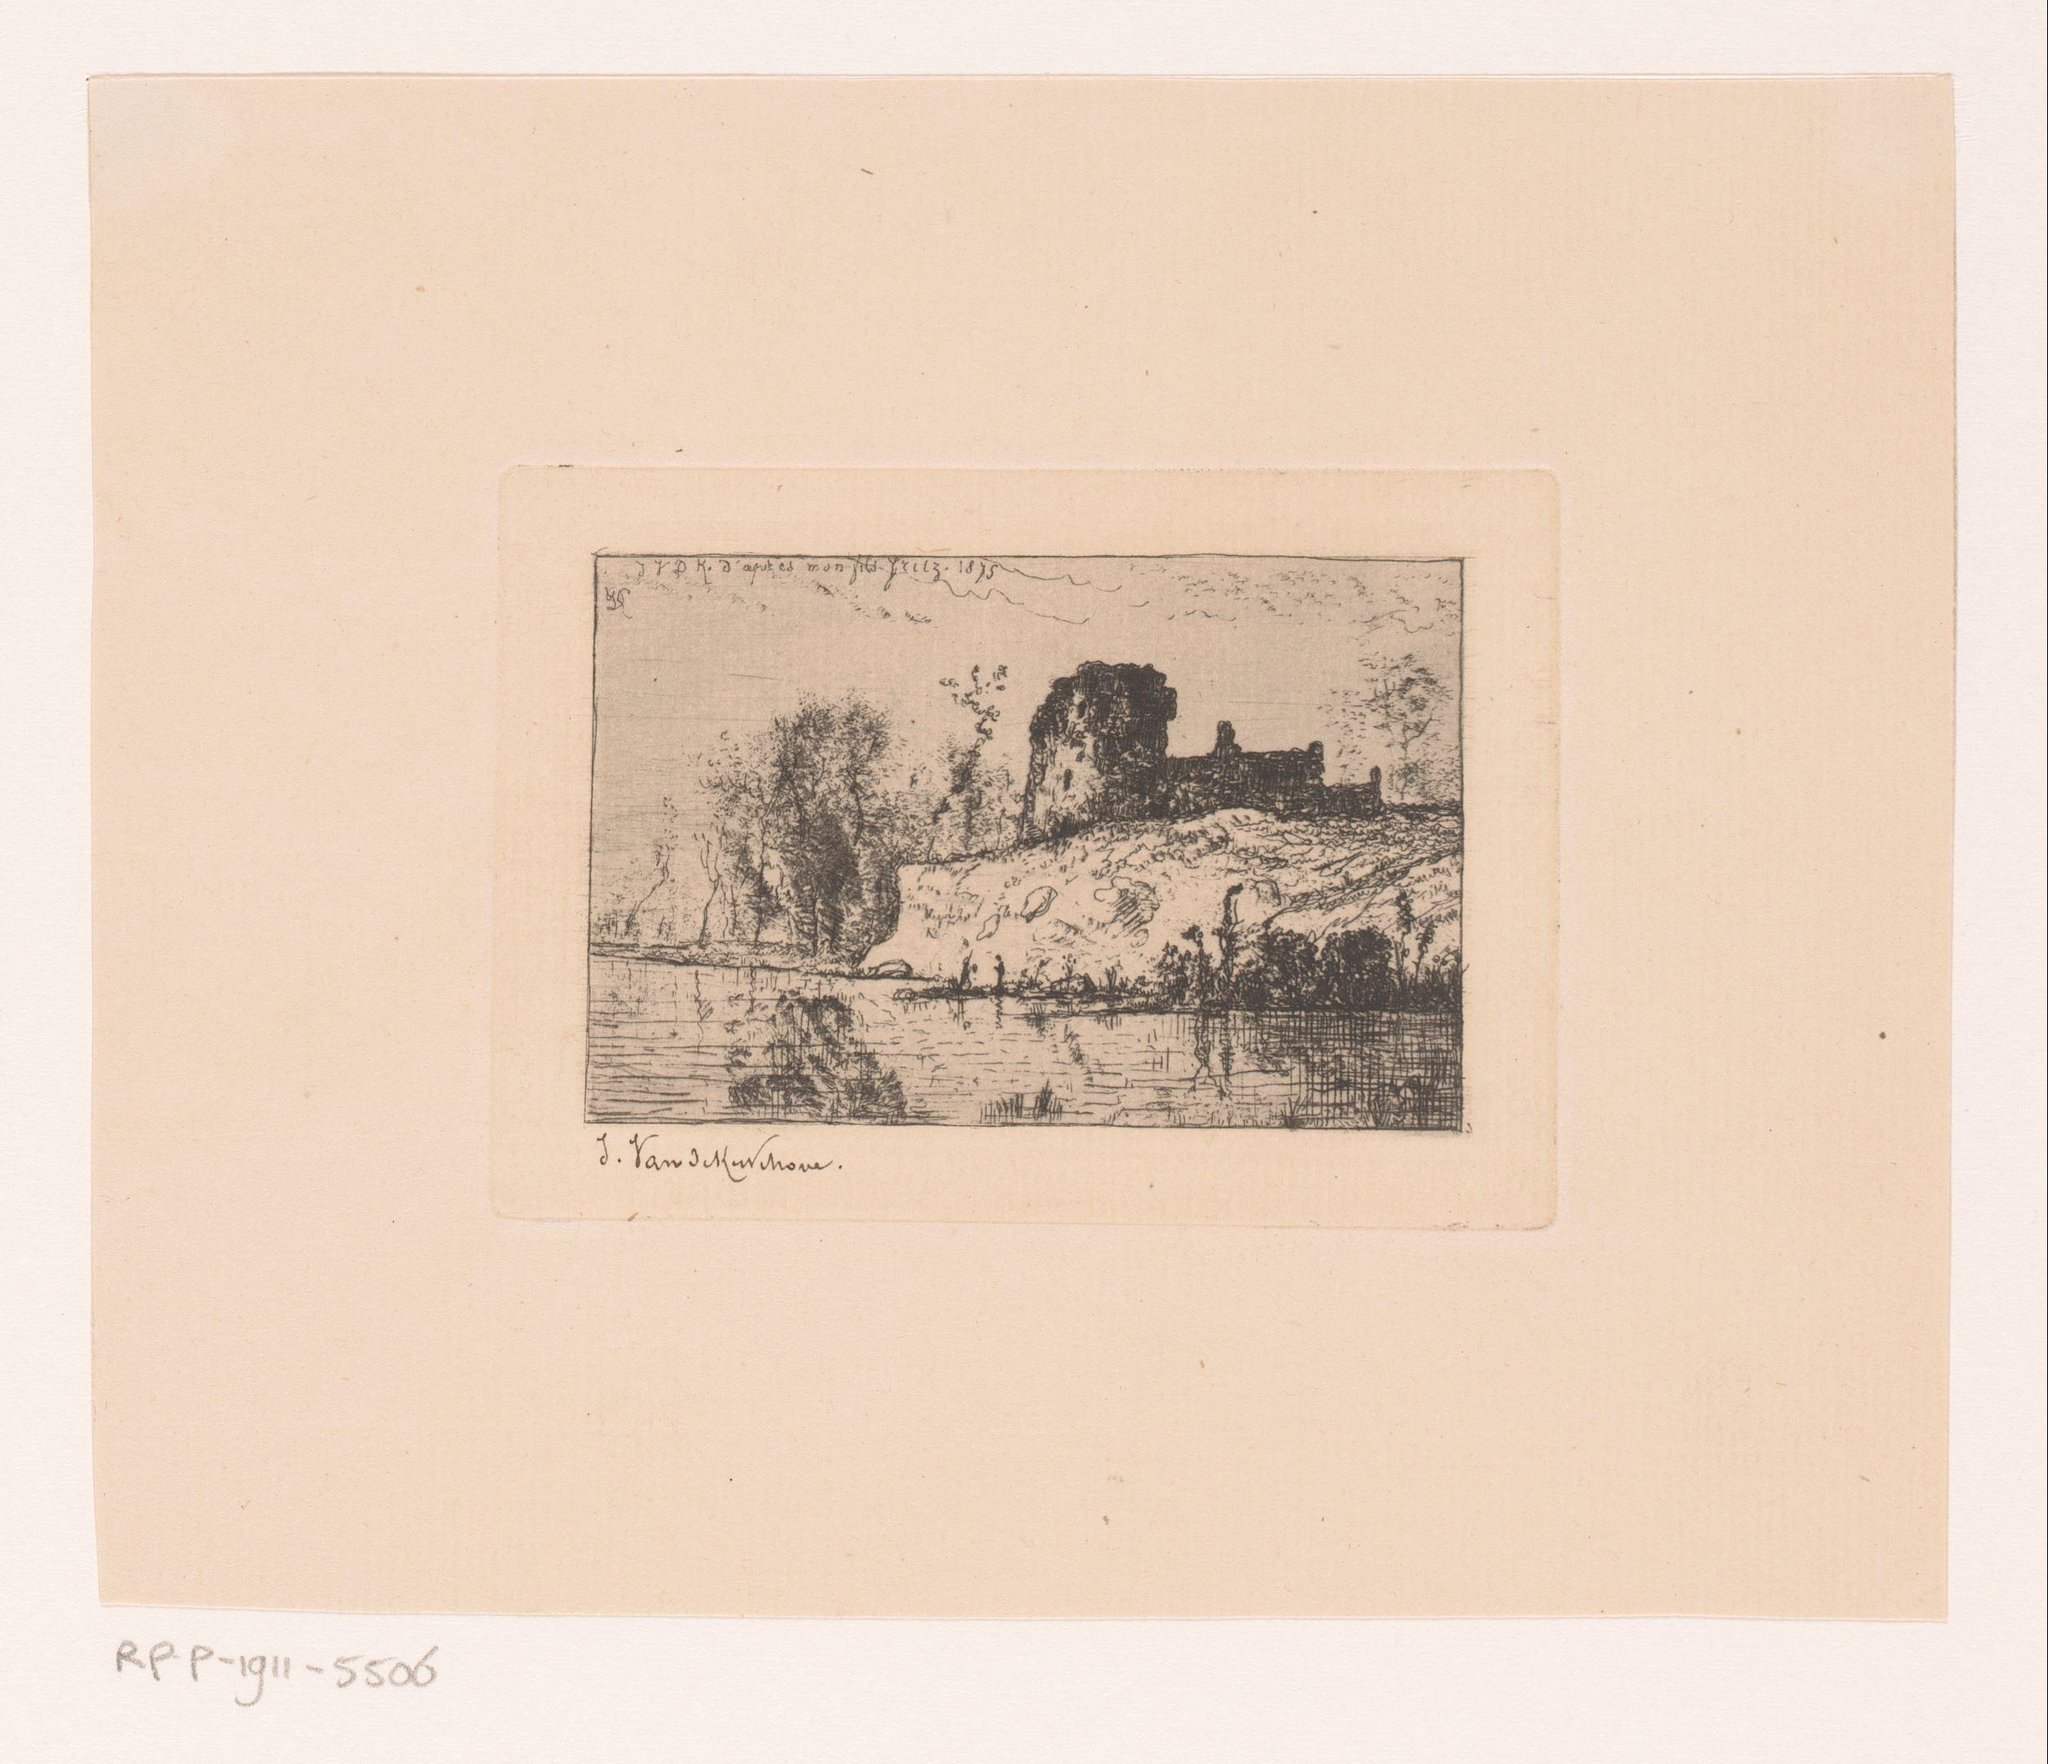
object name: print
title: Ruïne op een heuvel aan het water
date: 1875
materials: paper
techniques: drypoint, etching, intaglio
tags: (high) hill, landscape with ruins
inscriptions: collector's mark: Lugt 2228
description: De etsen naar de schilderijen van Frédéric Van de Kerkhove werden na zijn dood door zijn vader en zuster gemaakt en uitgegeven in twee reeksen. De eerste werd in 1877 uitgegeven door het Journal des Beaux-Arts et de la Littérature: Cahier de 25 Eaux-fortes d'après Frédéric van de Kerkhove, gravées par son père et sa sœur. De tweede reeks van 126 etsen, ook in 1877, werd in Parijs uitgegeven bij A. Lévy onder de titel Cent eaux-fortes gravées par J. Van de Kerkhove d'après les tableaux de Frédéric Van de Kerkhove, mort en 1873 à l'âge de 10 ans et 11 mois.